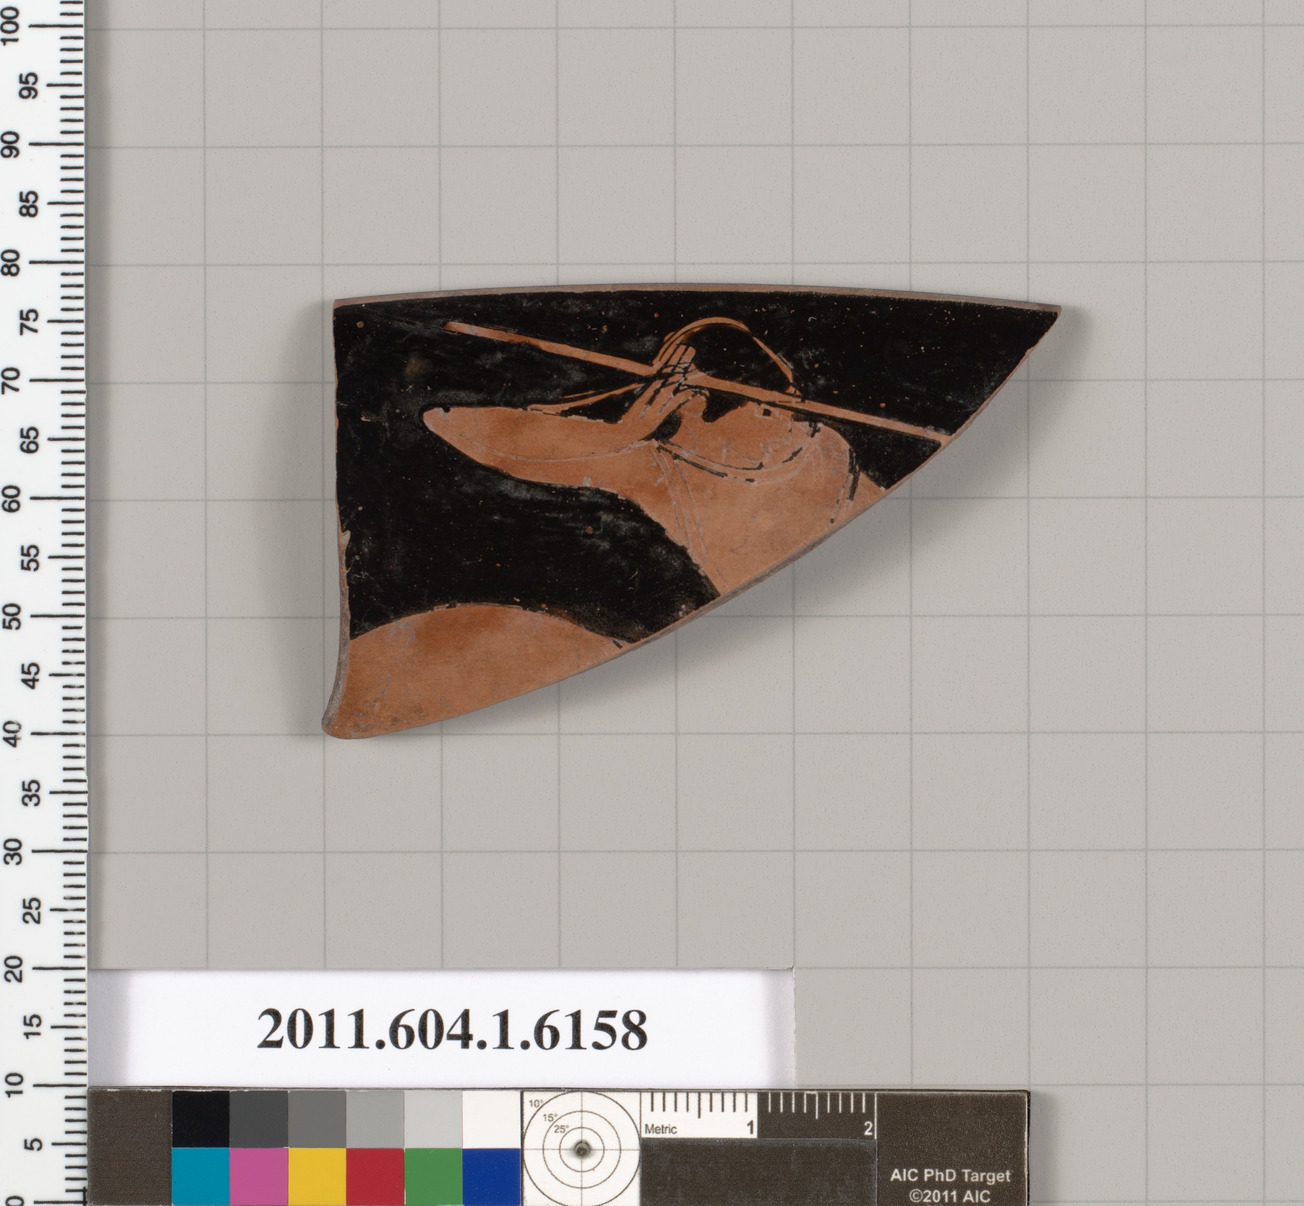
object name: kylix fragment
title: Terracotta rim fragment of a kylix (drinking cup)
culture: greek, attic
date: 520-500 BCE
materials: terracotta